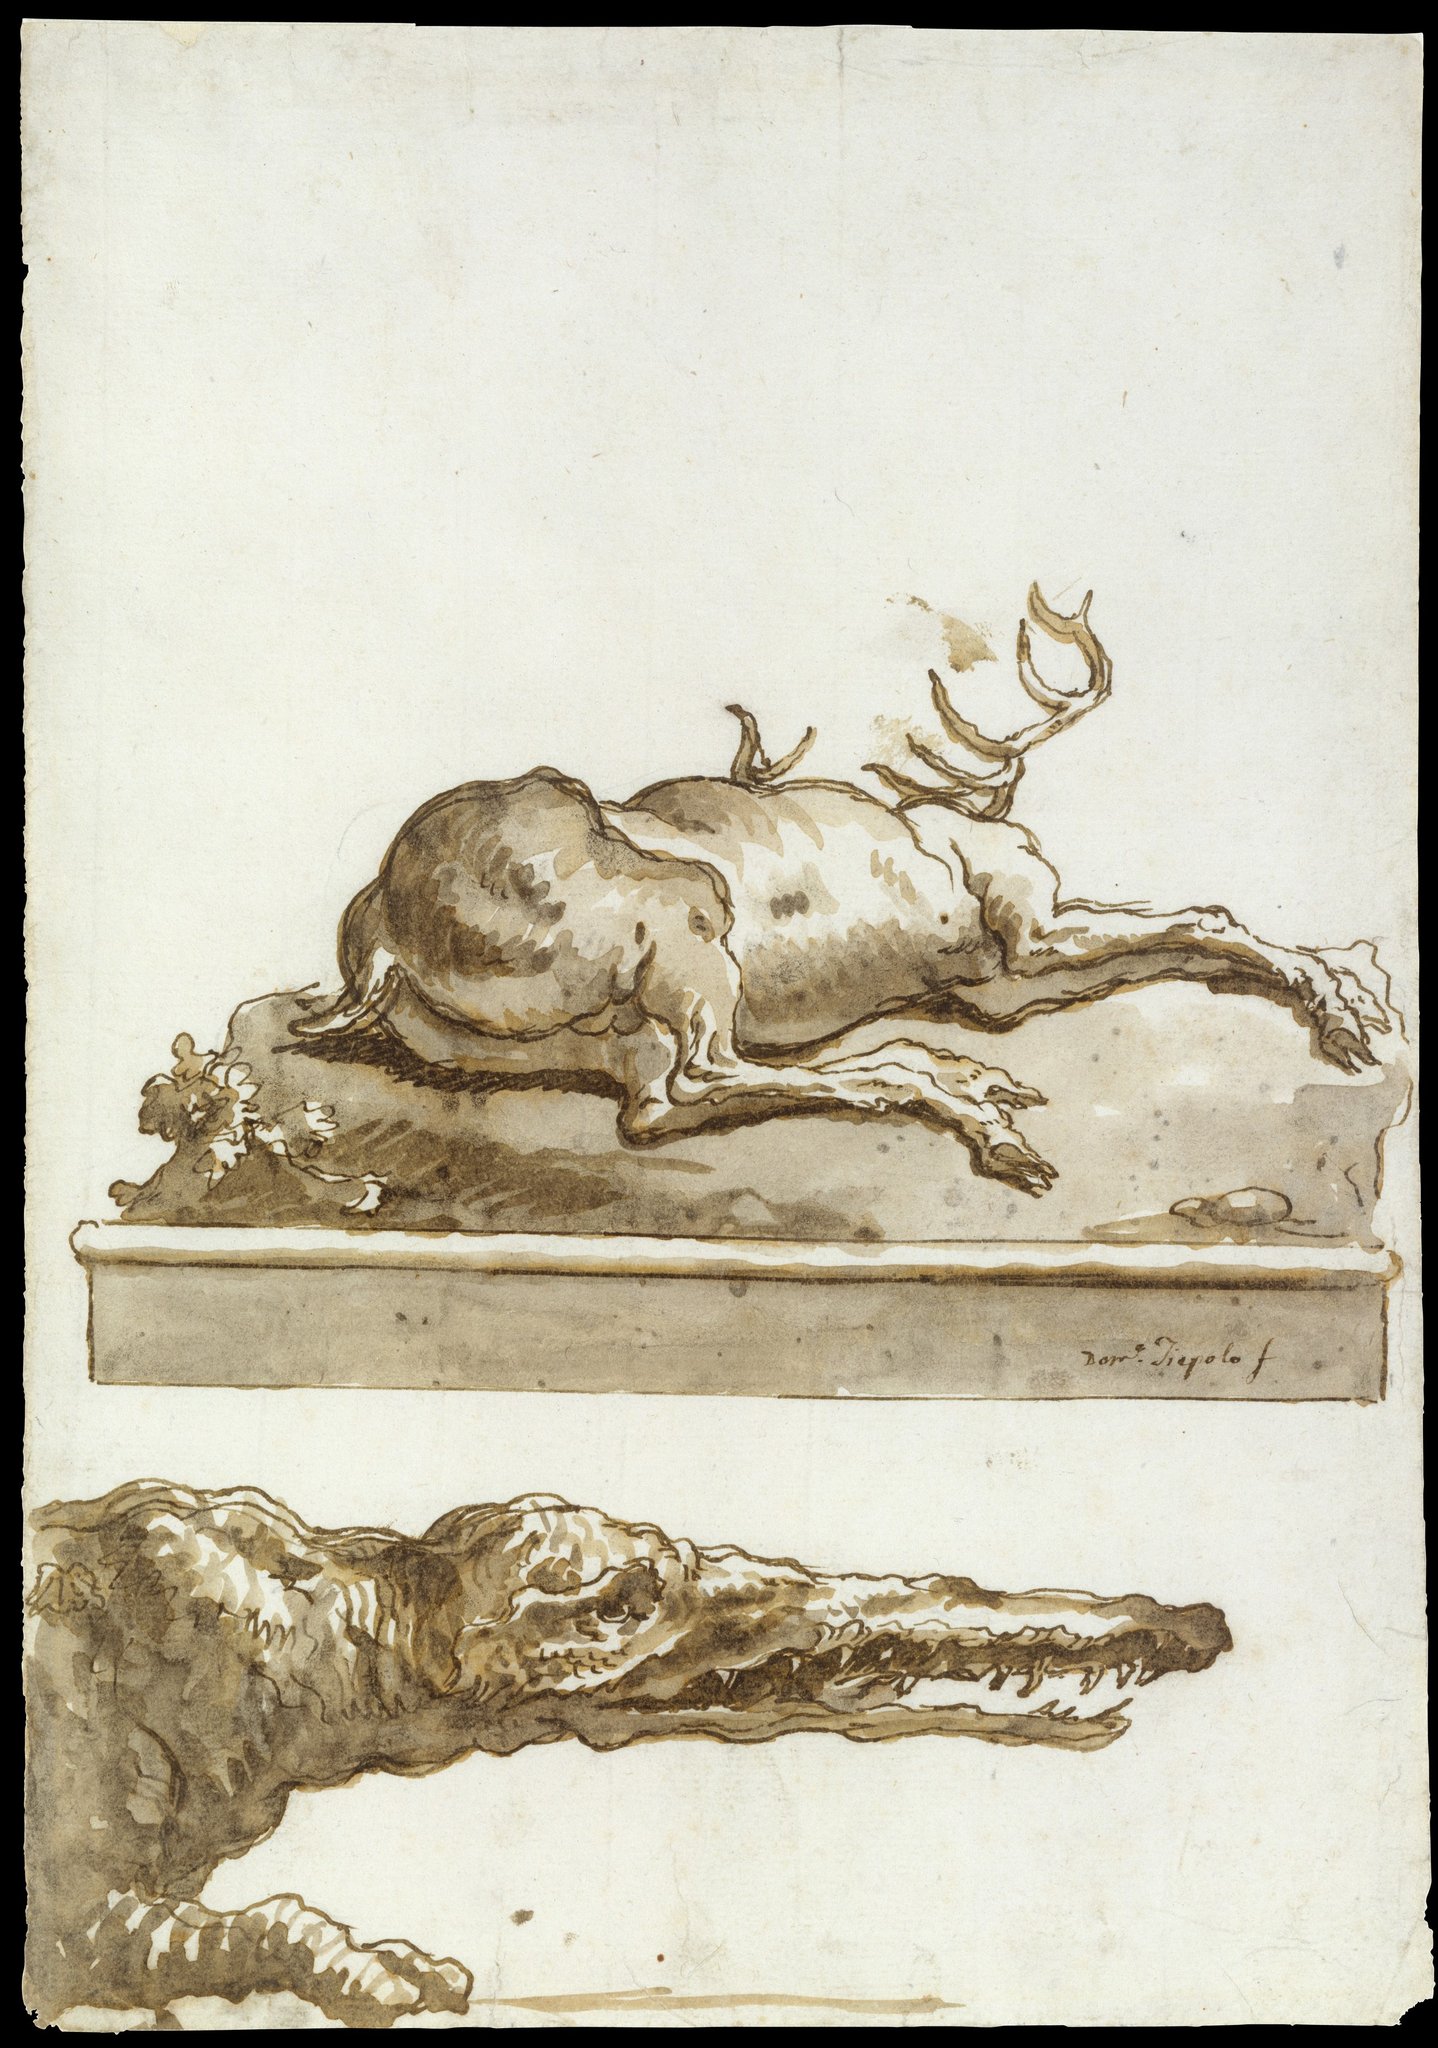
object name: drawing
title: A Stag Lying Down (on a base): The Head of a Crocodile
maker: giovanni domenico tiepolo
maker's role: artist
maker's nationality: italian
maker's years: 1727-1804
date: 1770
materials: chalk, ink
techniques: pen, wash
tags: crocodiles,deer